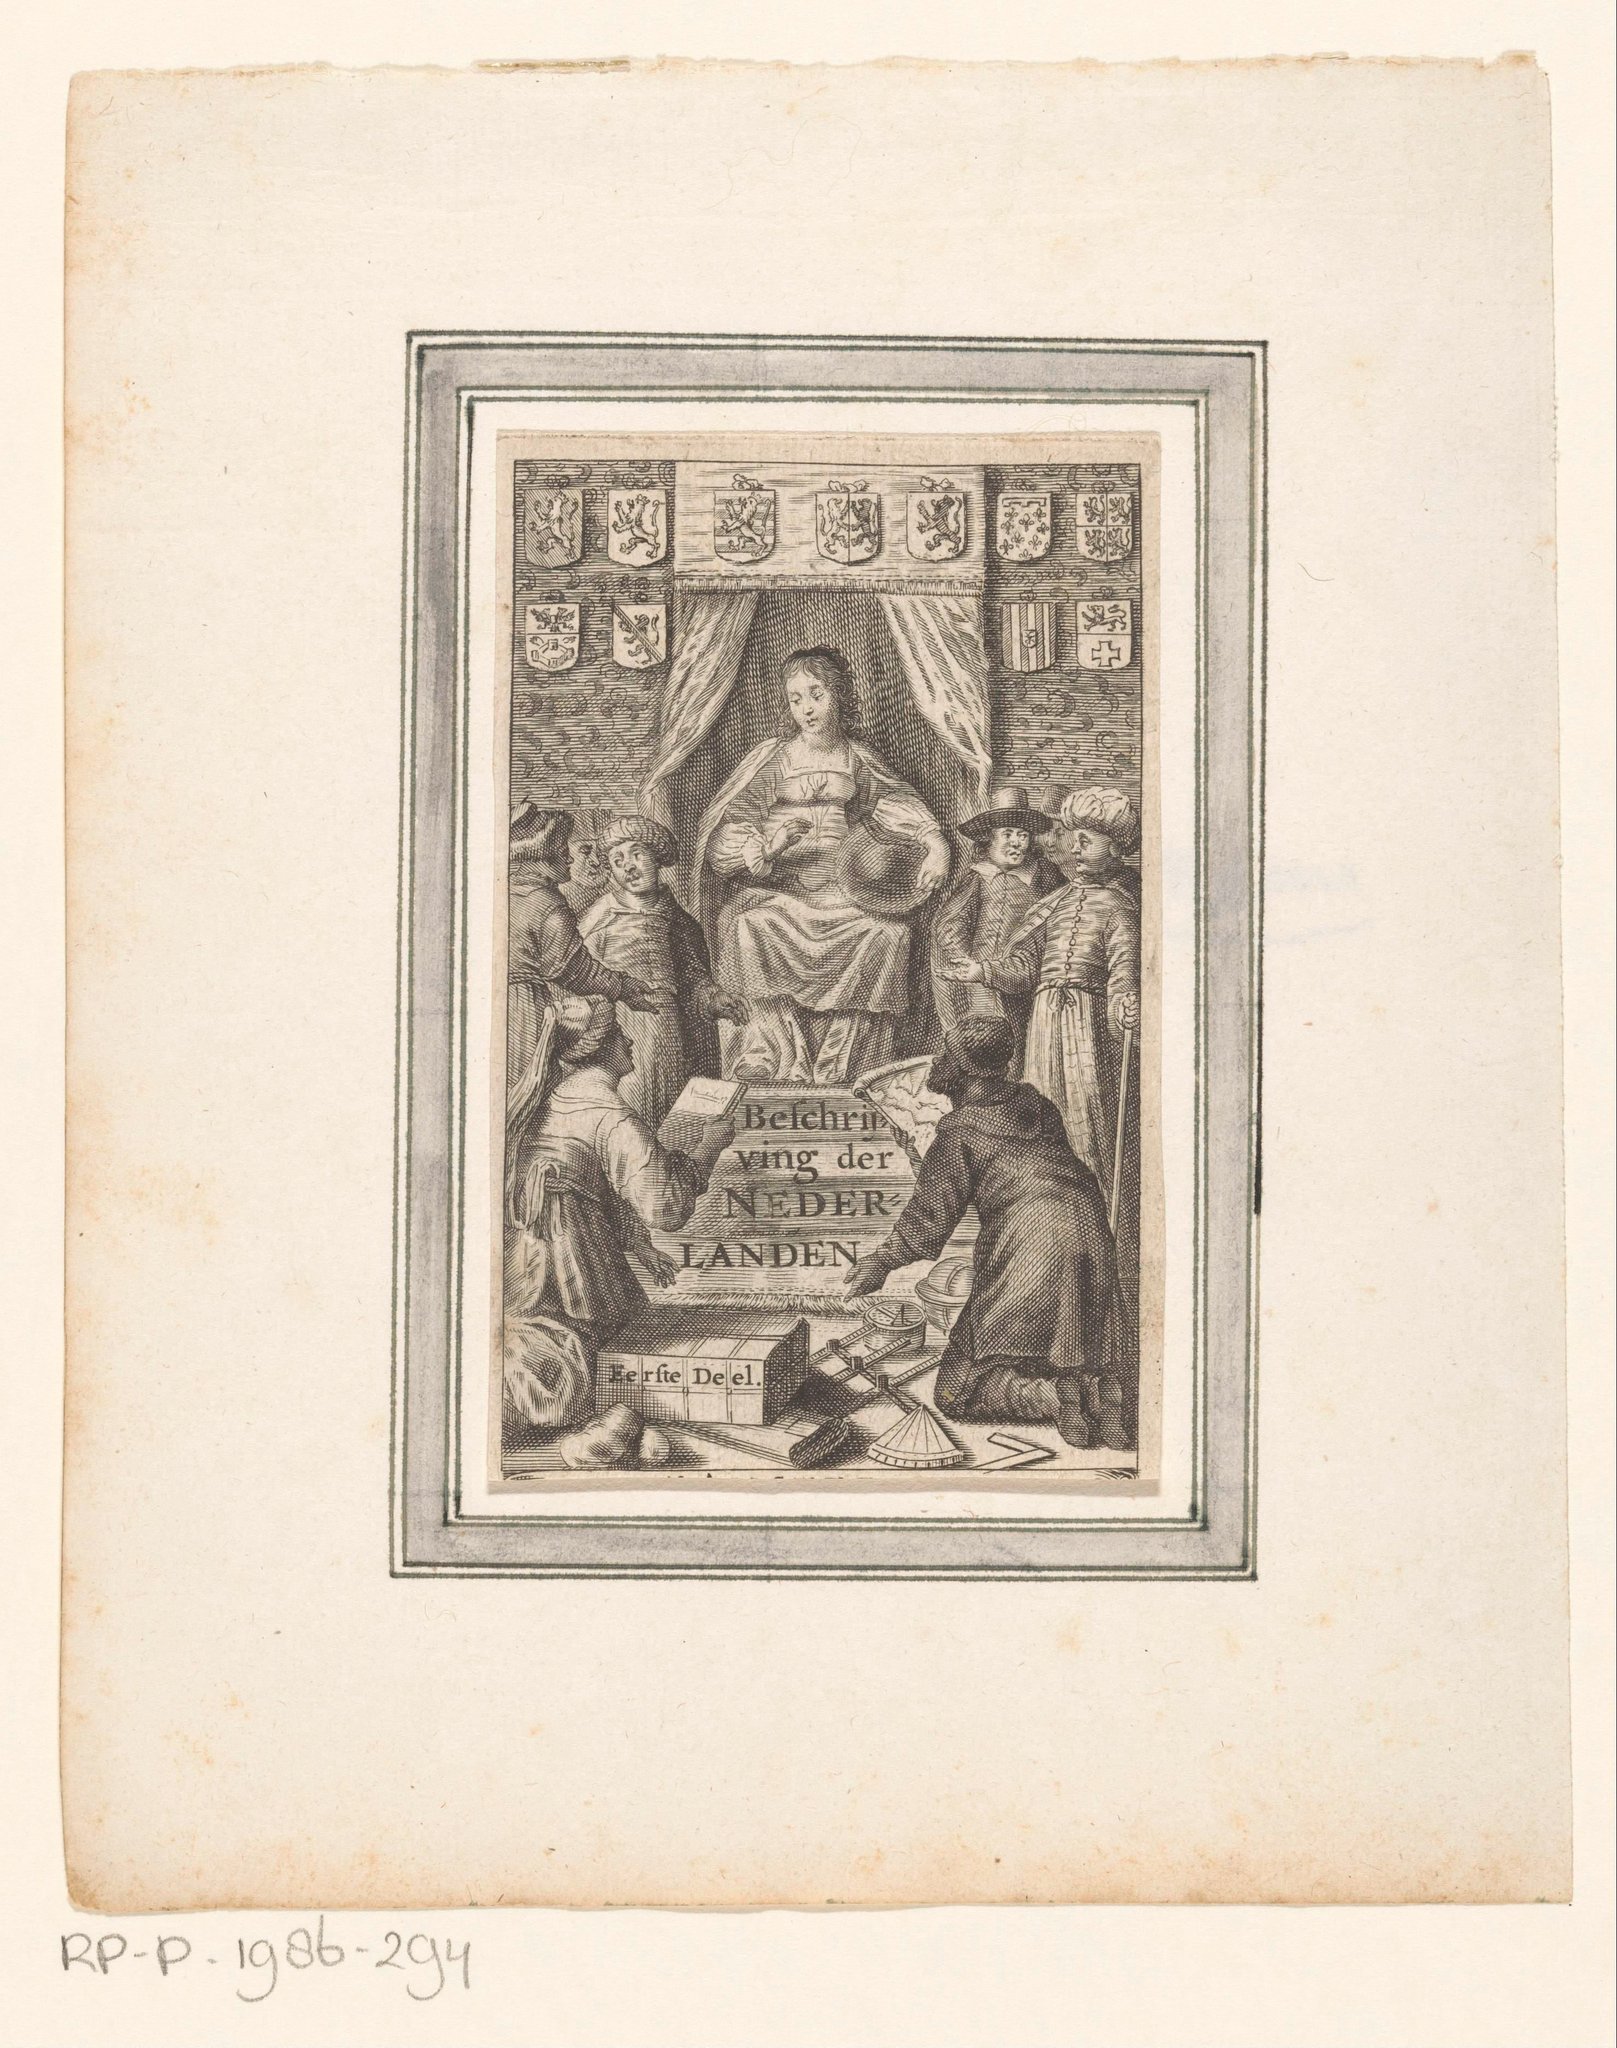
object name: print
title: Allegorische figuur op troon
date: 1662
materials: paper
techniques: engraving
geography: amsterdam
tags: sitting figure - aa - female human figure, throne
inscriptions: collector's mark: Lugt 2228, collector's mark: Lugt 2760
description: Een vrouw met globe zittend op een troon omringd door mannen van verschillende afkomst. Voor haar zitten twee geknielde mannen met een boek en landkaart in de hand.